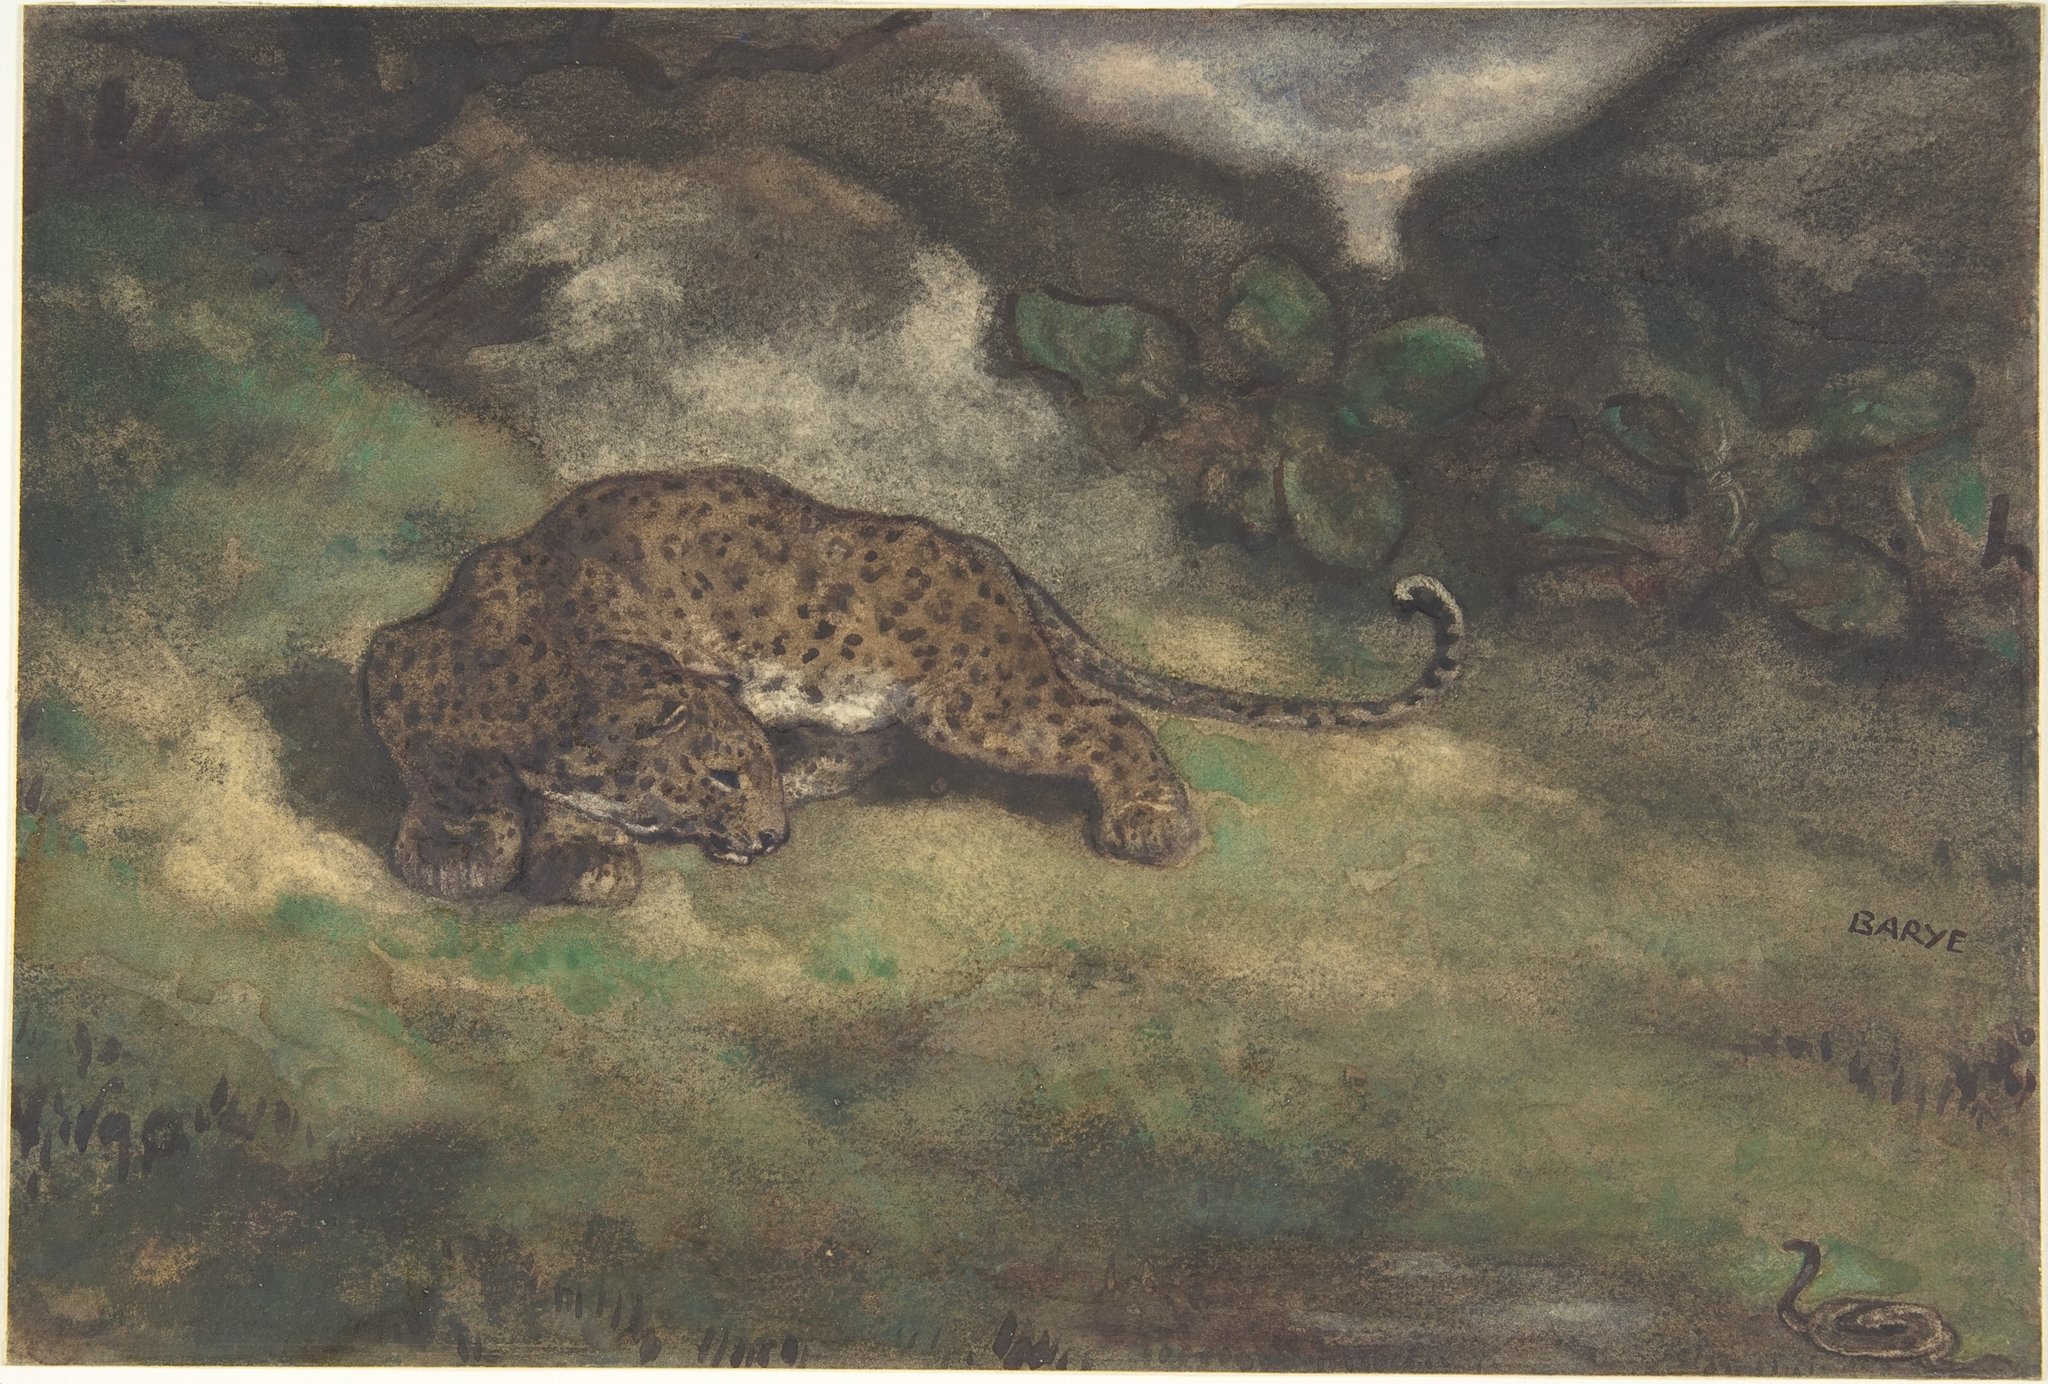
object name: drawing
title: Leopard and Serpent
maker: antoine-louis barye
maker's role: artist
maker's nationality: french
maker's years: 1795-1875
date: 1810-1875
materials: paper, watercolor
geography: france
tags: leopards,serpents